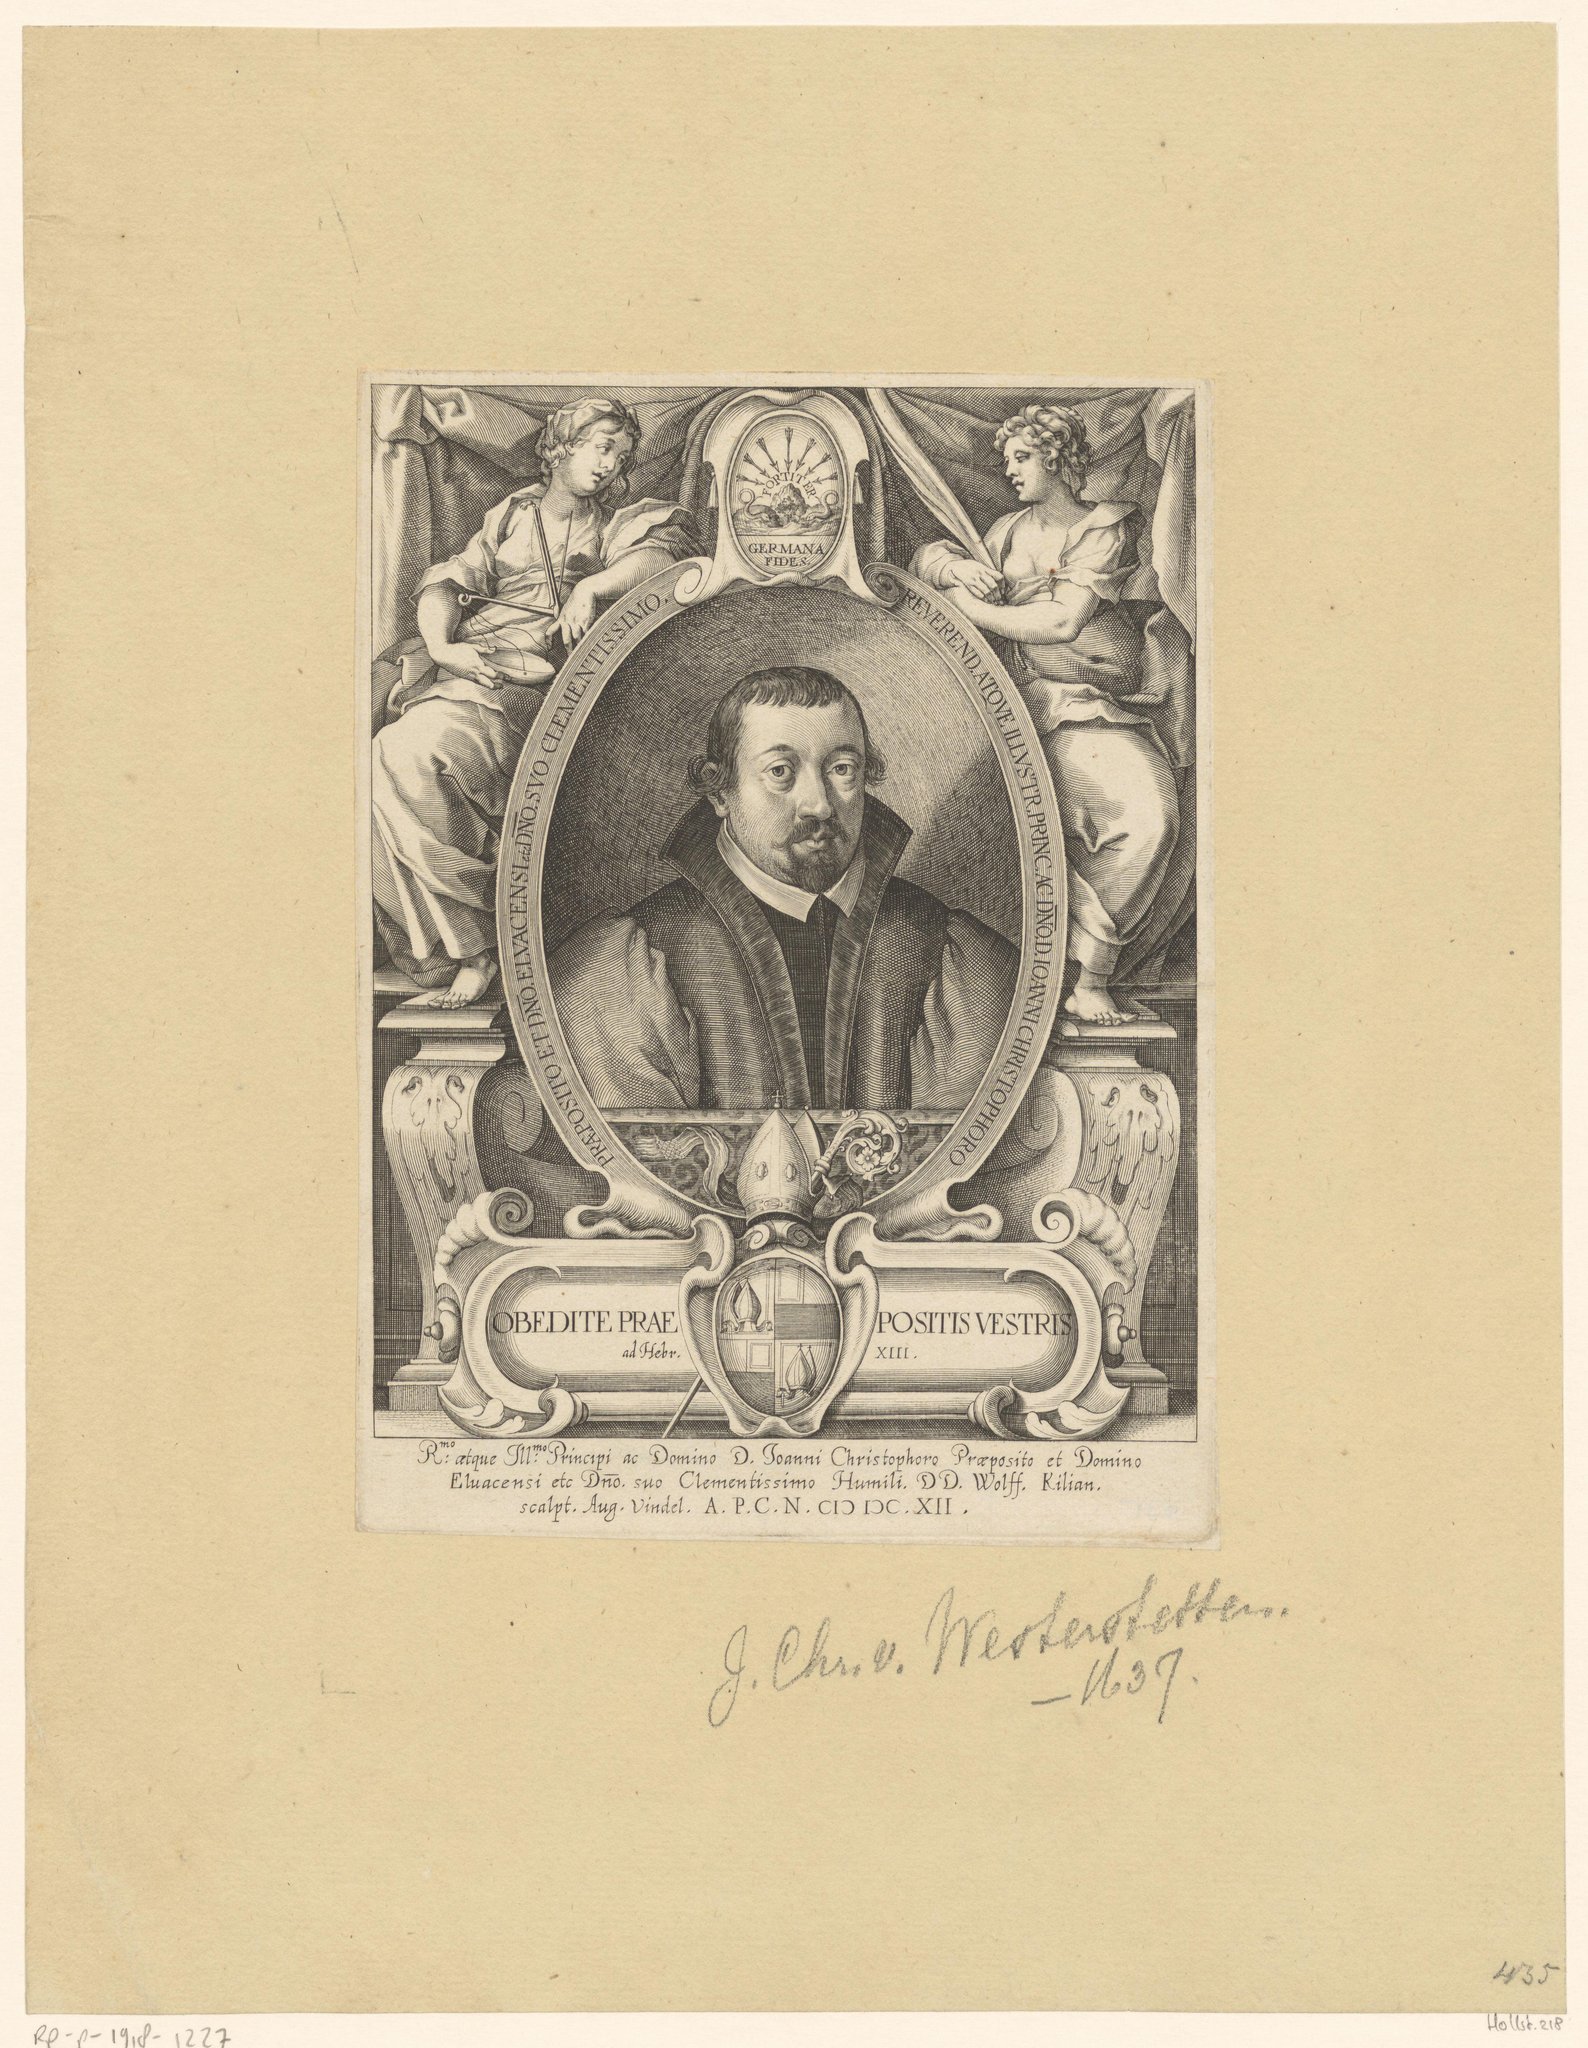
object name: print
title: Portret van Johann Christoph von Westerstetten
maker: wolfgang kilian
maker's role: print maker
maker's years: 1581-1662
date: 1612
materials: paper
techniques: engraving, etching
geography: augsburg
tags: eichstätt, archbishop, bishop, etc. (roman catholic), historical persons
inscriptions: collector's mark: Lugt 2228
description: Tekst in het Latijn in de omlijsting en in de ondermarge. Geportretteerde geflankeerd door de personificaties van Trouw en Gerechtigheid.